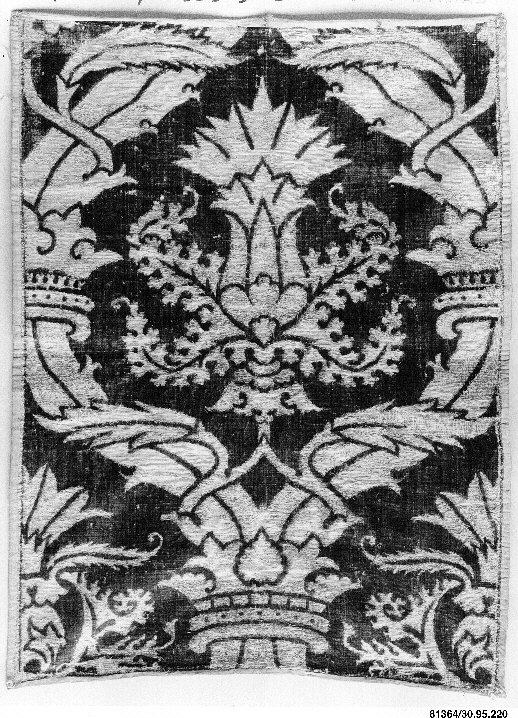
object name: strip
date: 1501-1600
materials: metal thread, silk, velvet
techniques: cutting, voiding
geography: turkey